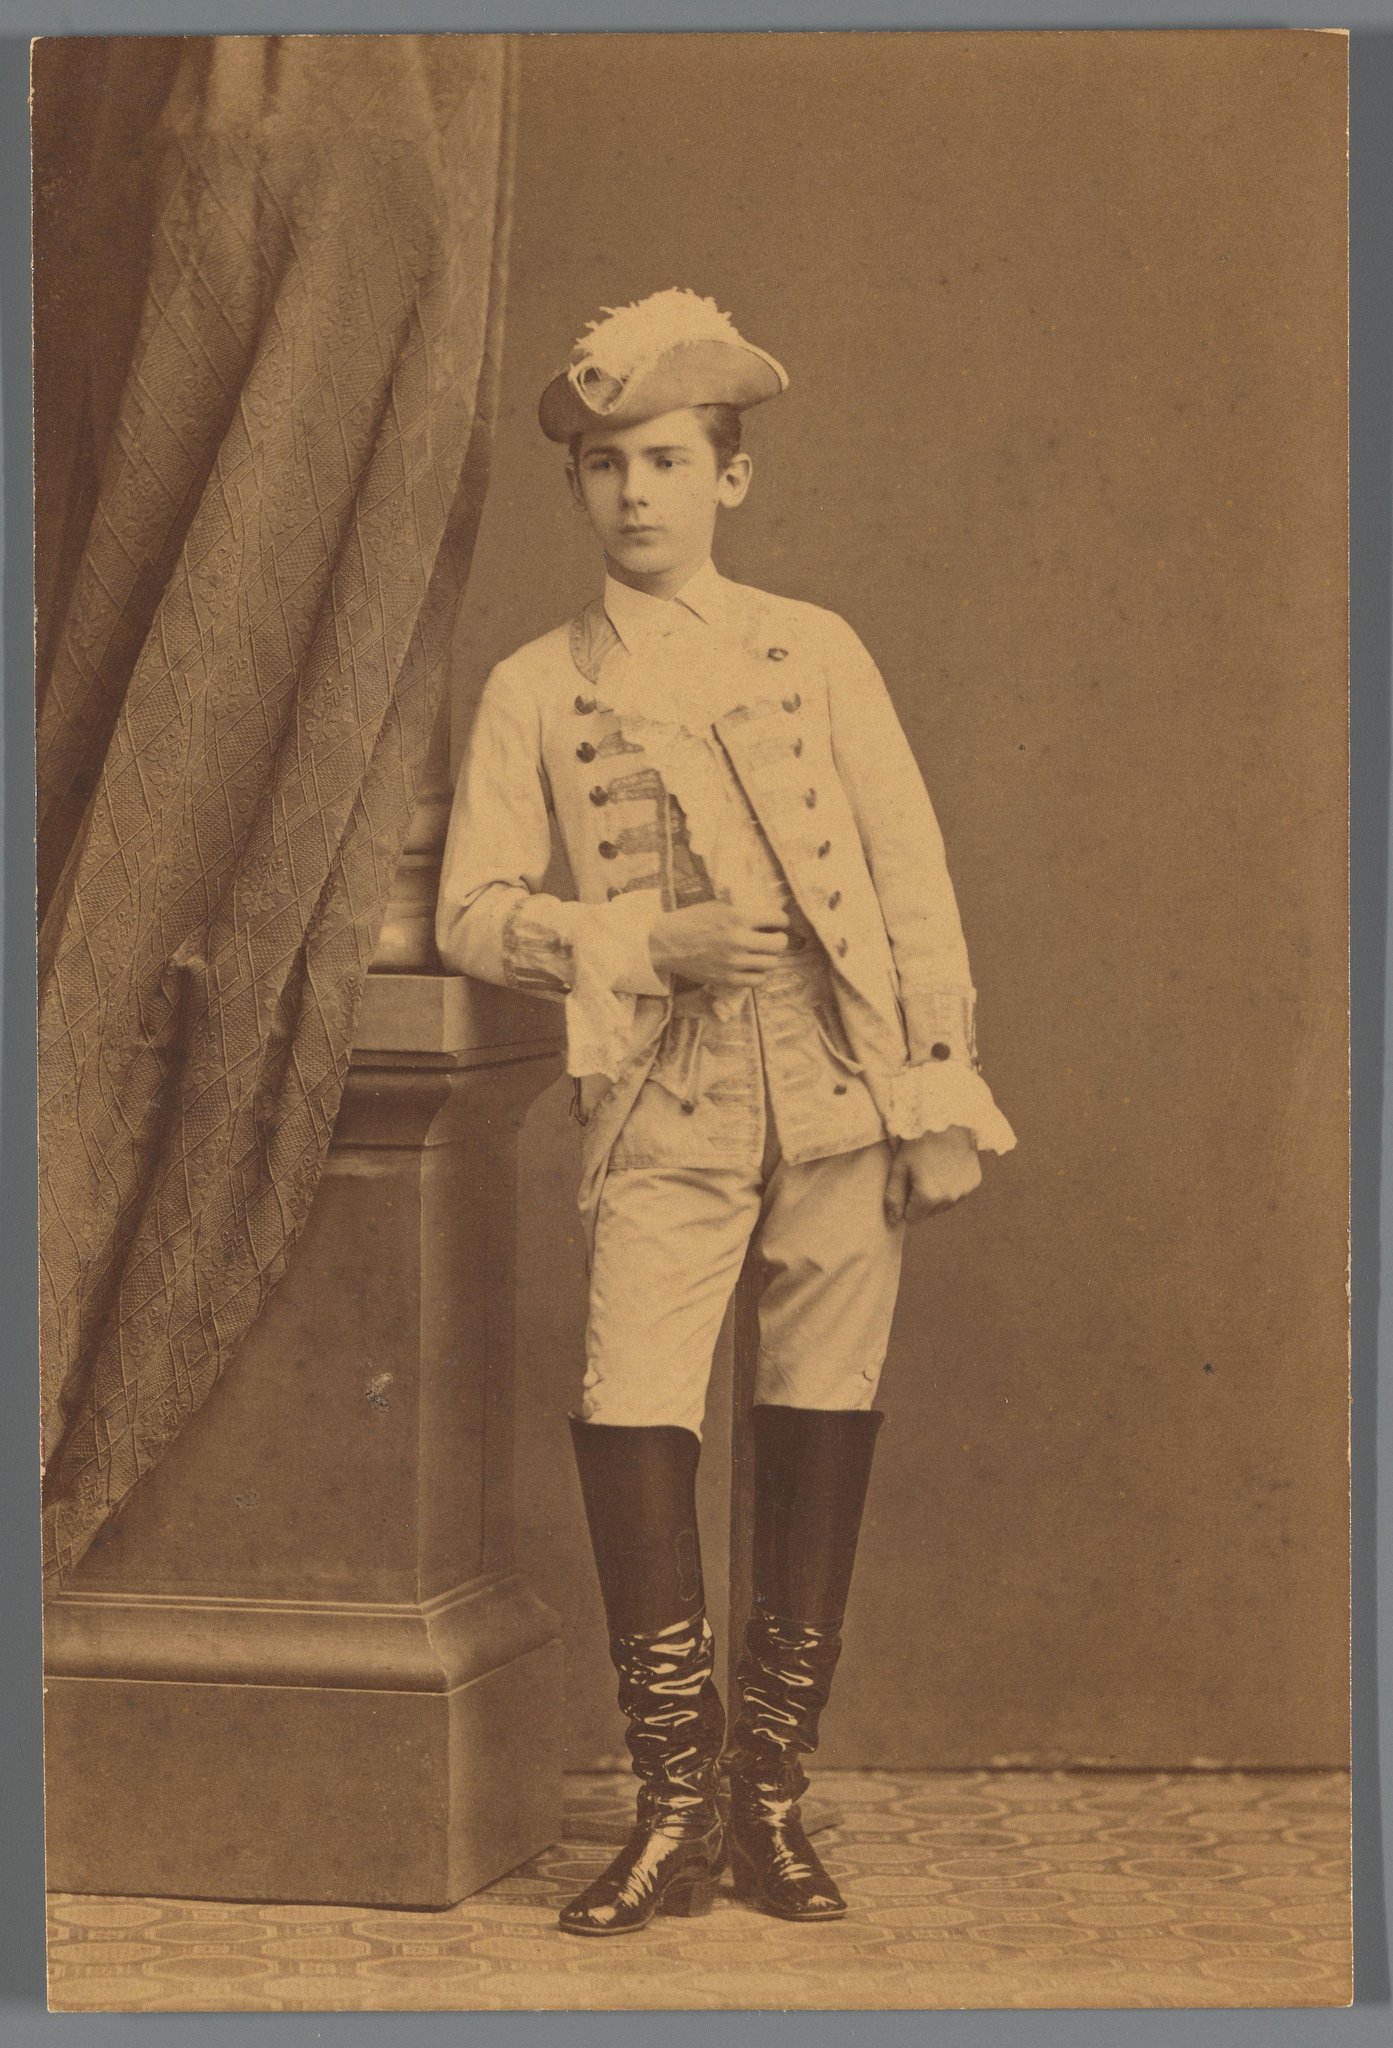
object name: cabinet photograph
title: Studioportret van van den Berg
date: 1870-1900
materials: cardboard, photographic support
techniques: albumen print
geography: batavia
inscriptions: name: ‘WOODBURY & PAGE / Photographers / JAVA.’, inscription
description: Staande jongeman met driekantige steek en kniehoge laarzen, leunend op een sokkel.